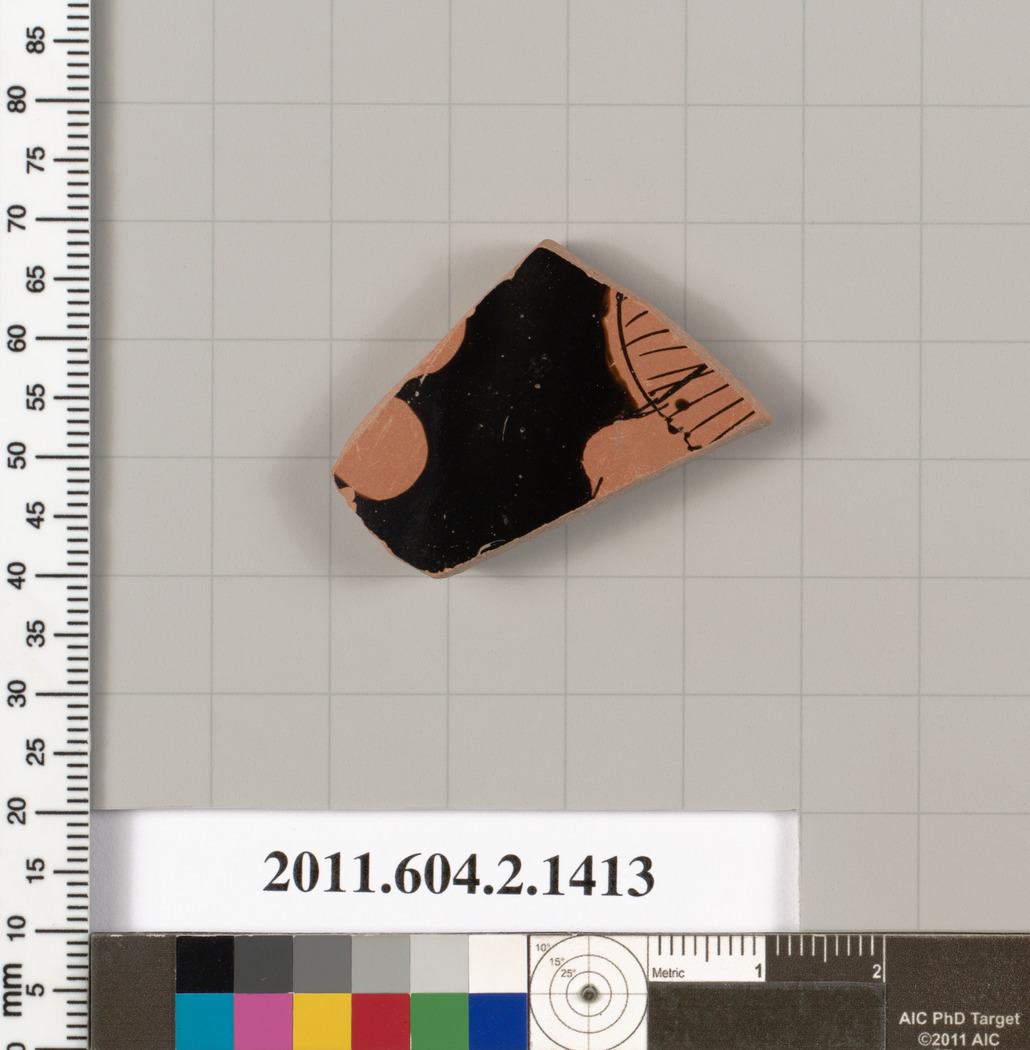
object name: skyphos fragment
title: Terracotta fragment of a skyphos (deep drinking cup)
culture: greek, attic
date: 480-470 BCE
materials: terracotta